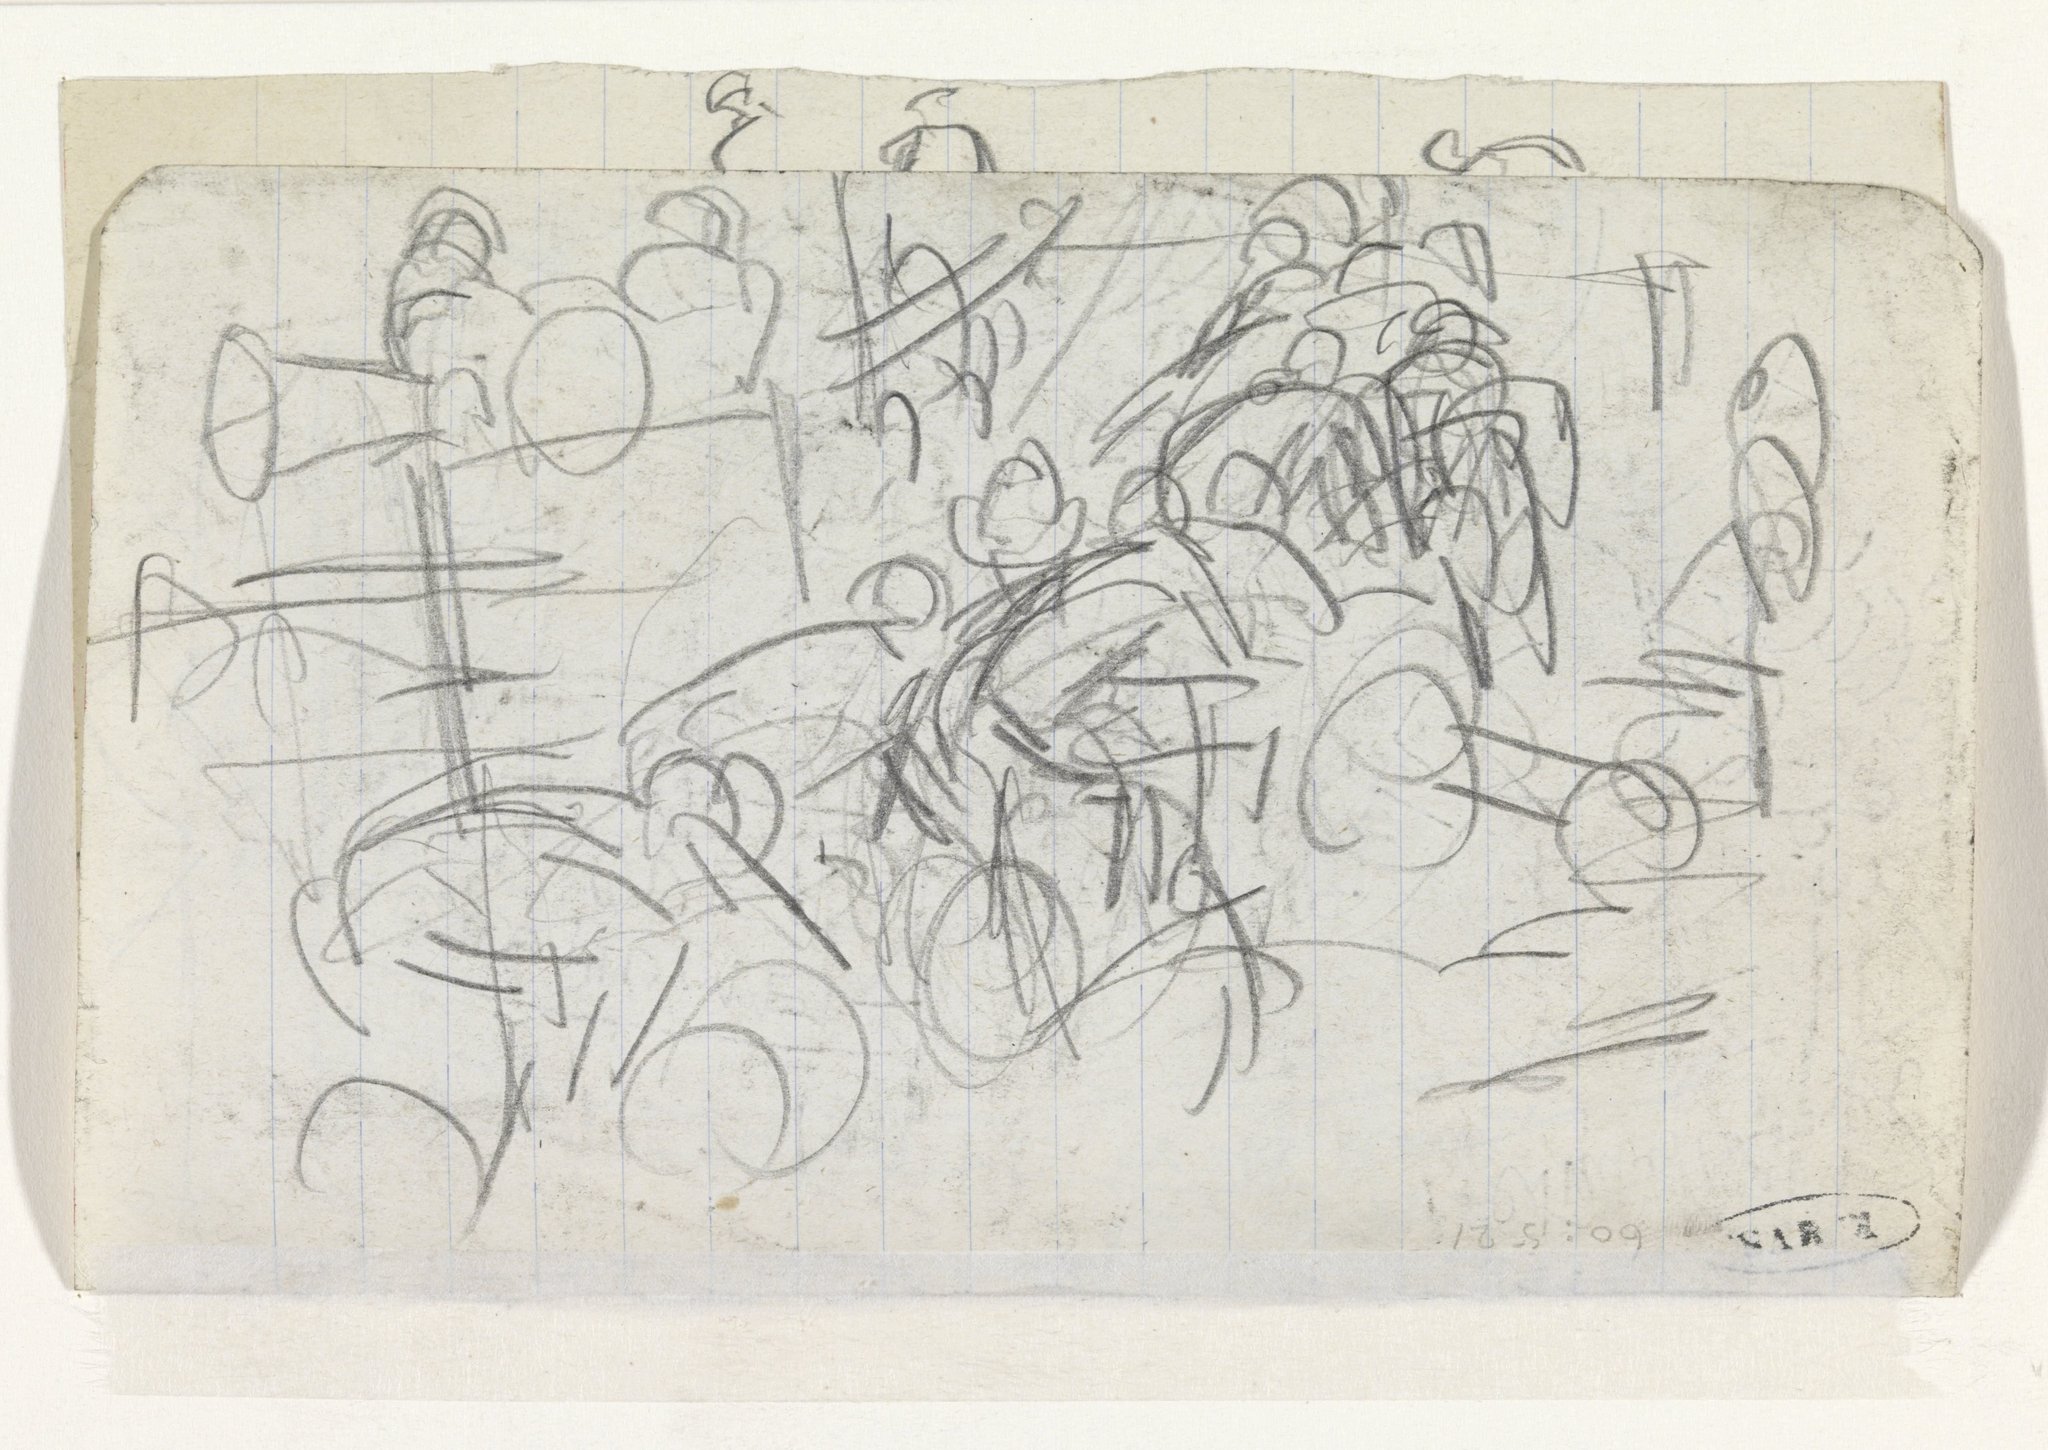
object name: drawing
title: Wielrenners rijden een wedstrijd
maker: leo gestel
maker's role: draughtsman, print maker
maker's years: 1881-1941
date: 1891-1941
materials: pencil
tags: bicycle racing